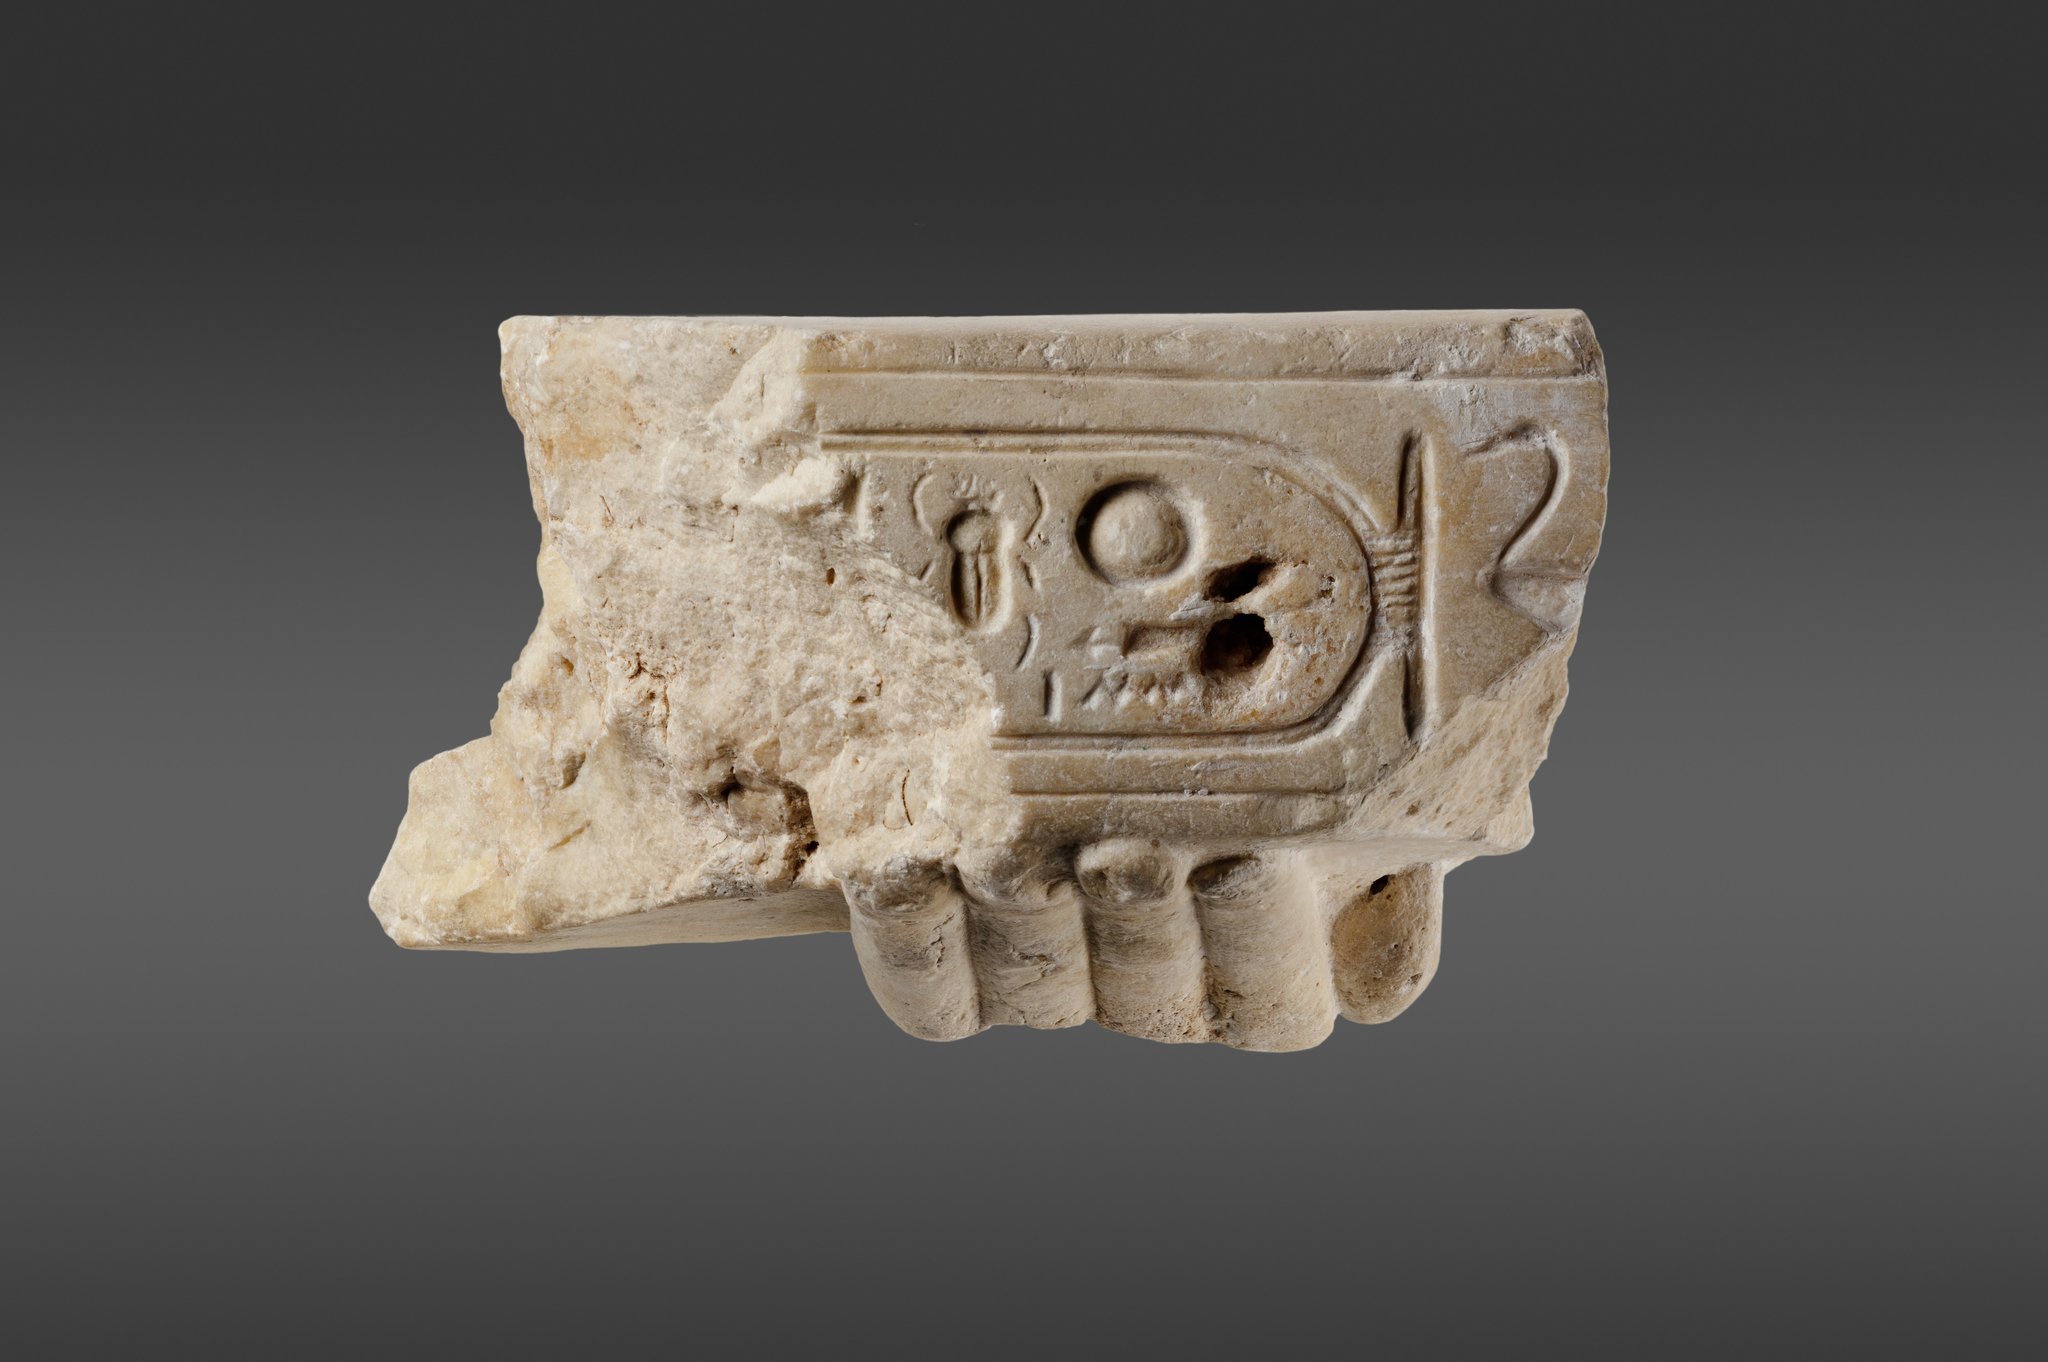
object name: offering table with hand, akhenaten name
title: Offering table with hand, Akhenaten names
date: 1353-1336 BCE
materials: limestone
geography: egypt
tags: hands,hieroglyphs